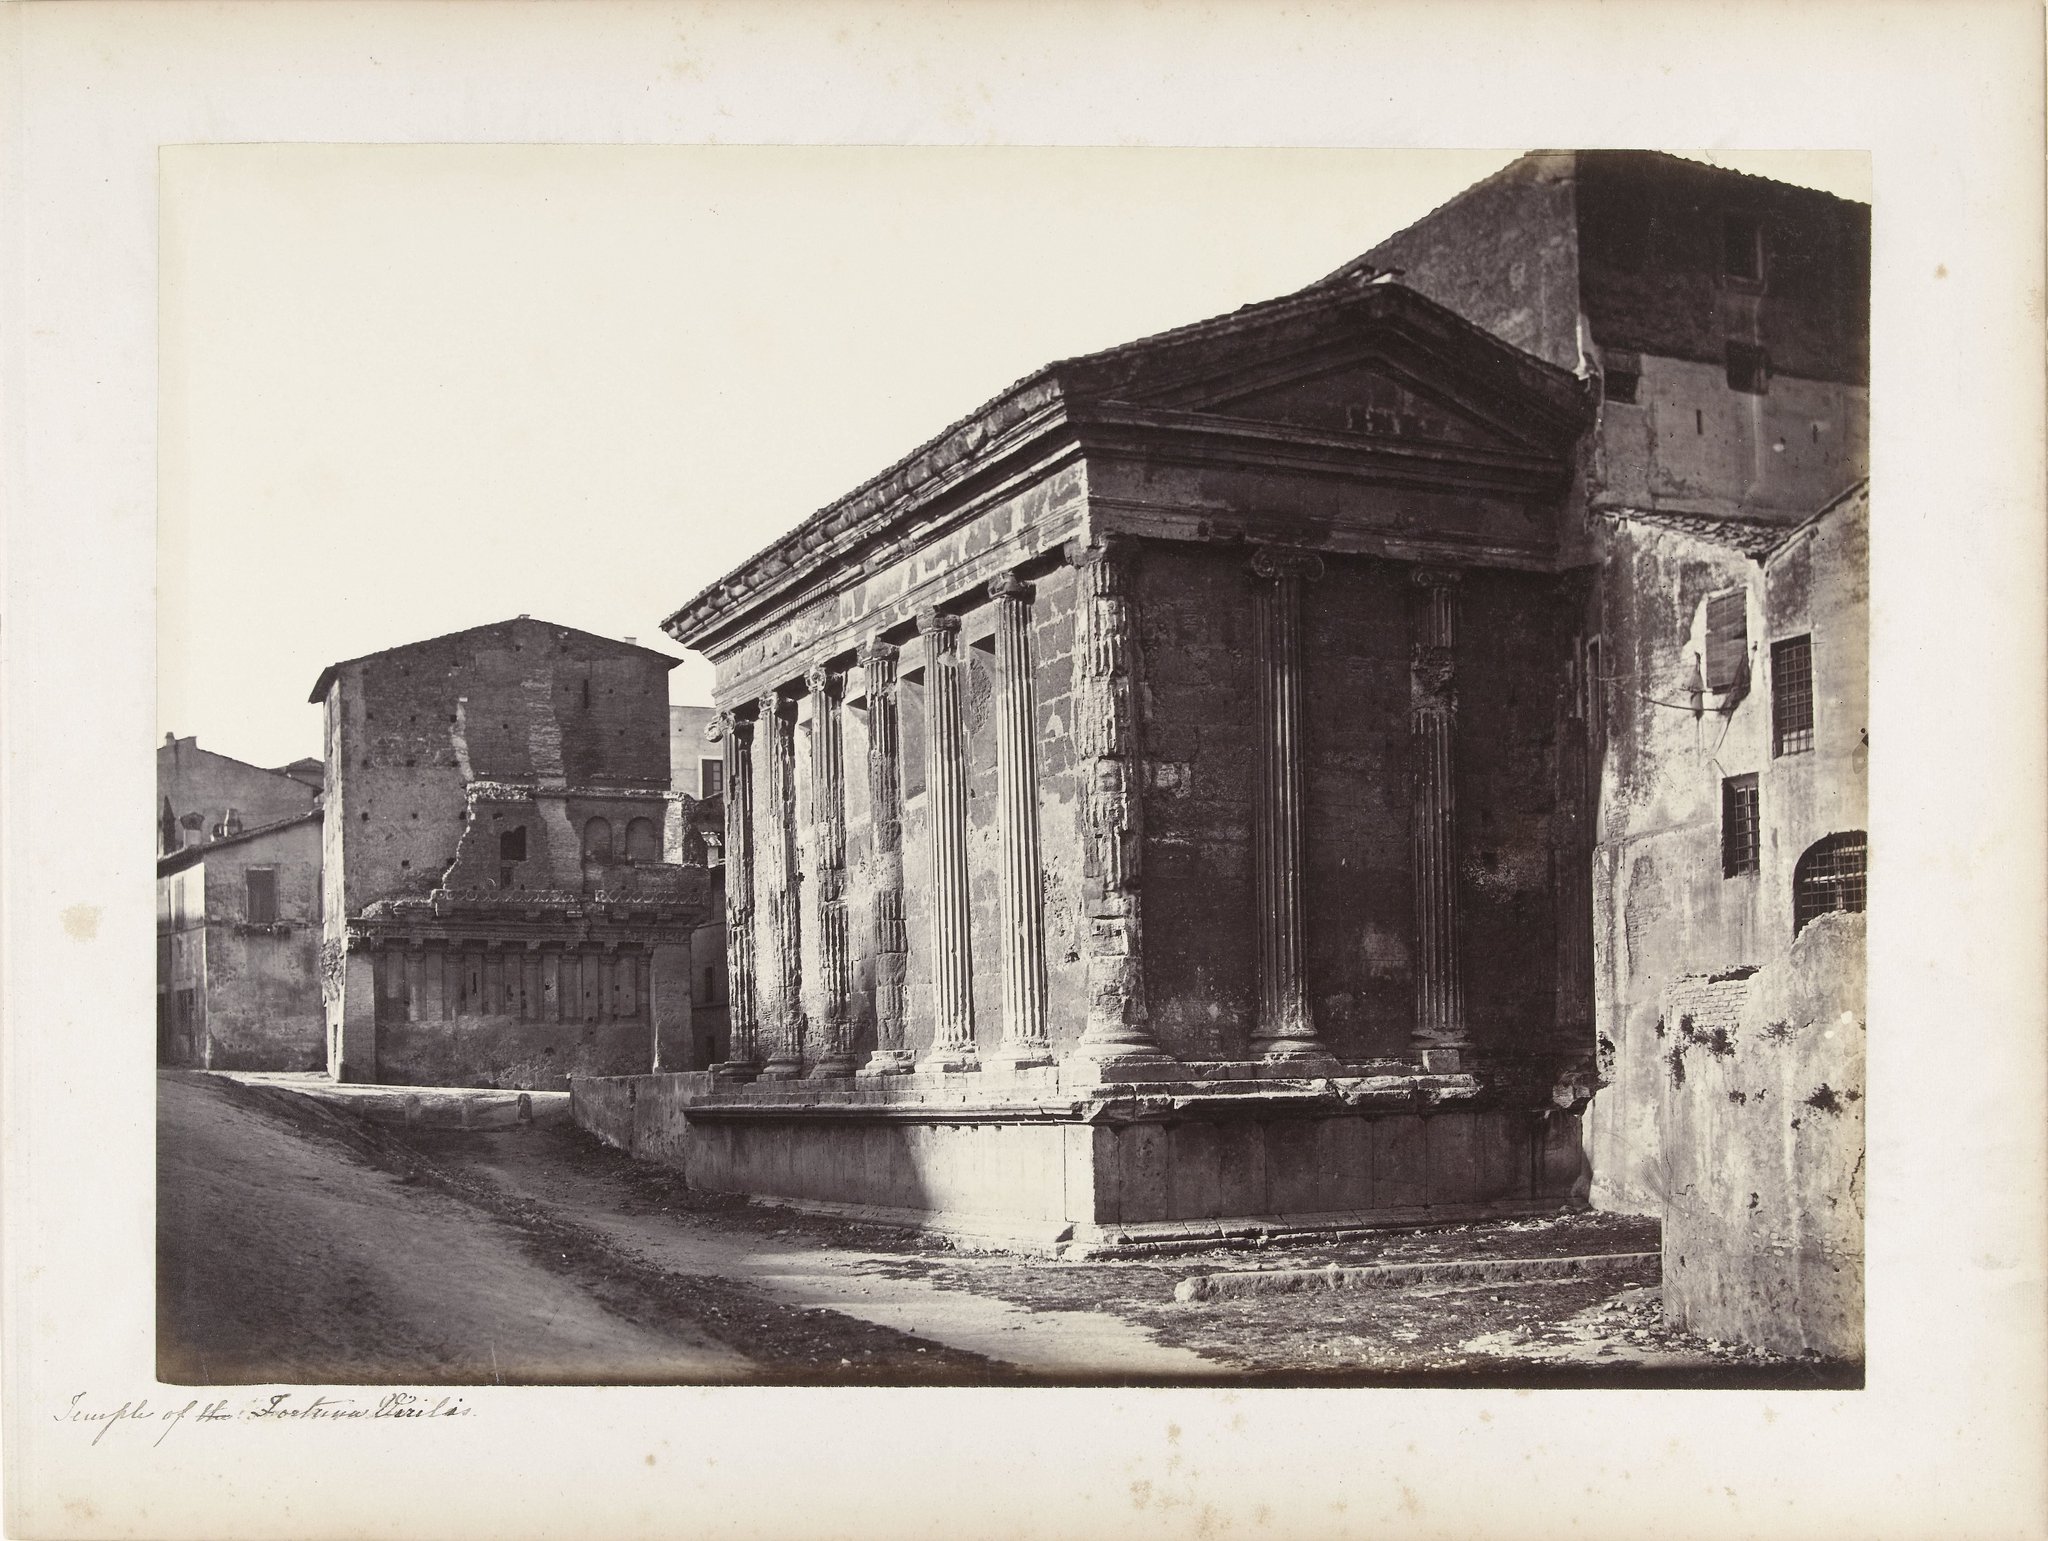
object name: photograph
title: Temple of the Fortuna Virilis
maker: Anonymous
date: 1851-1900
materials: cardboard, paper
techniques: albumen print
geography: rome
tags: temple, shrine ~ roman religion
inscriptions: number: ‘166’